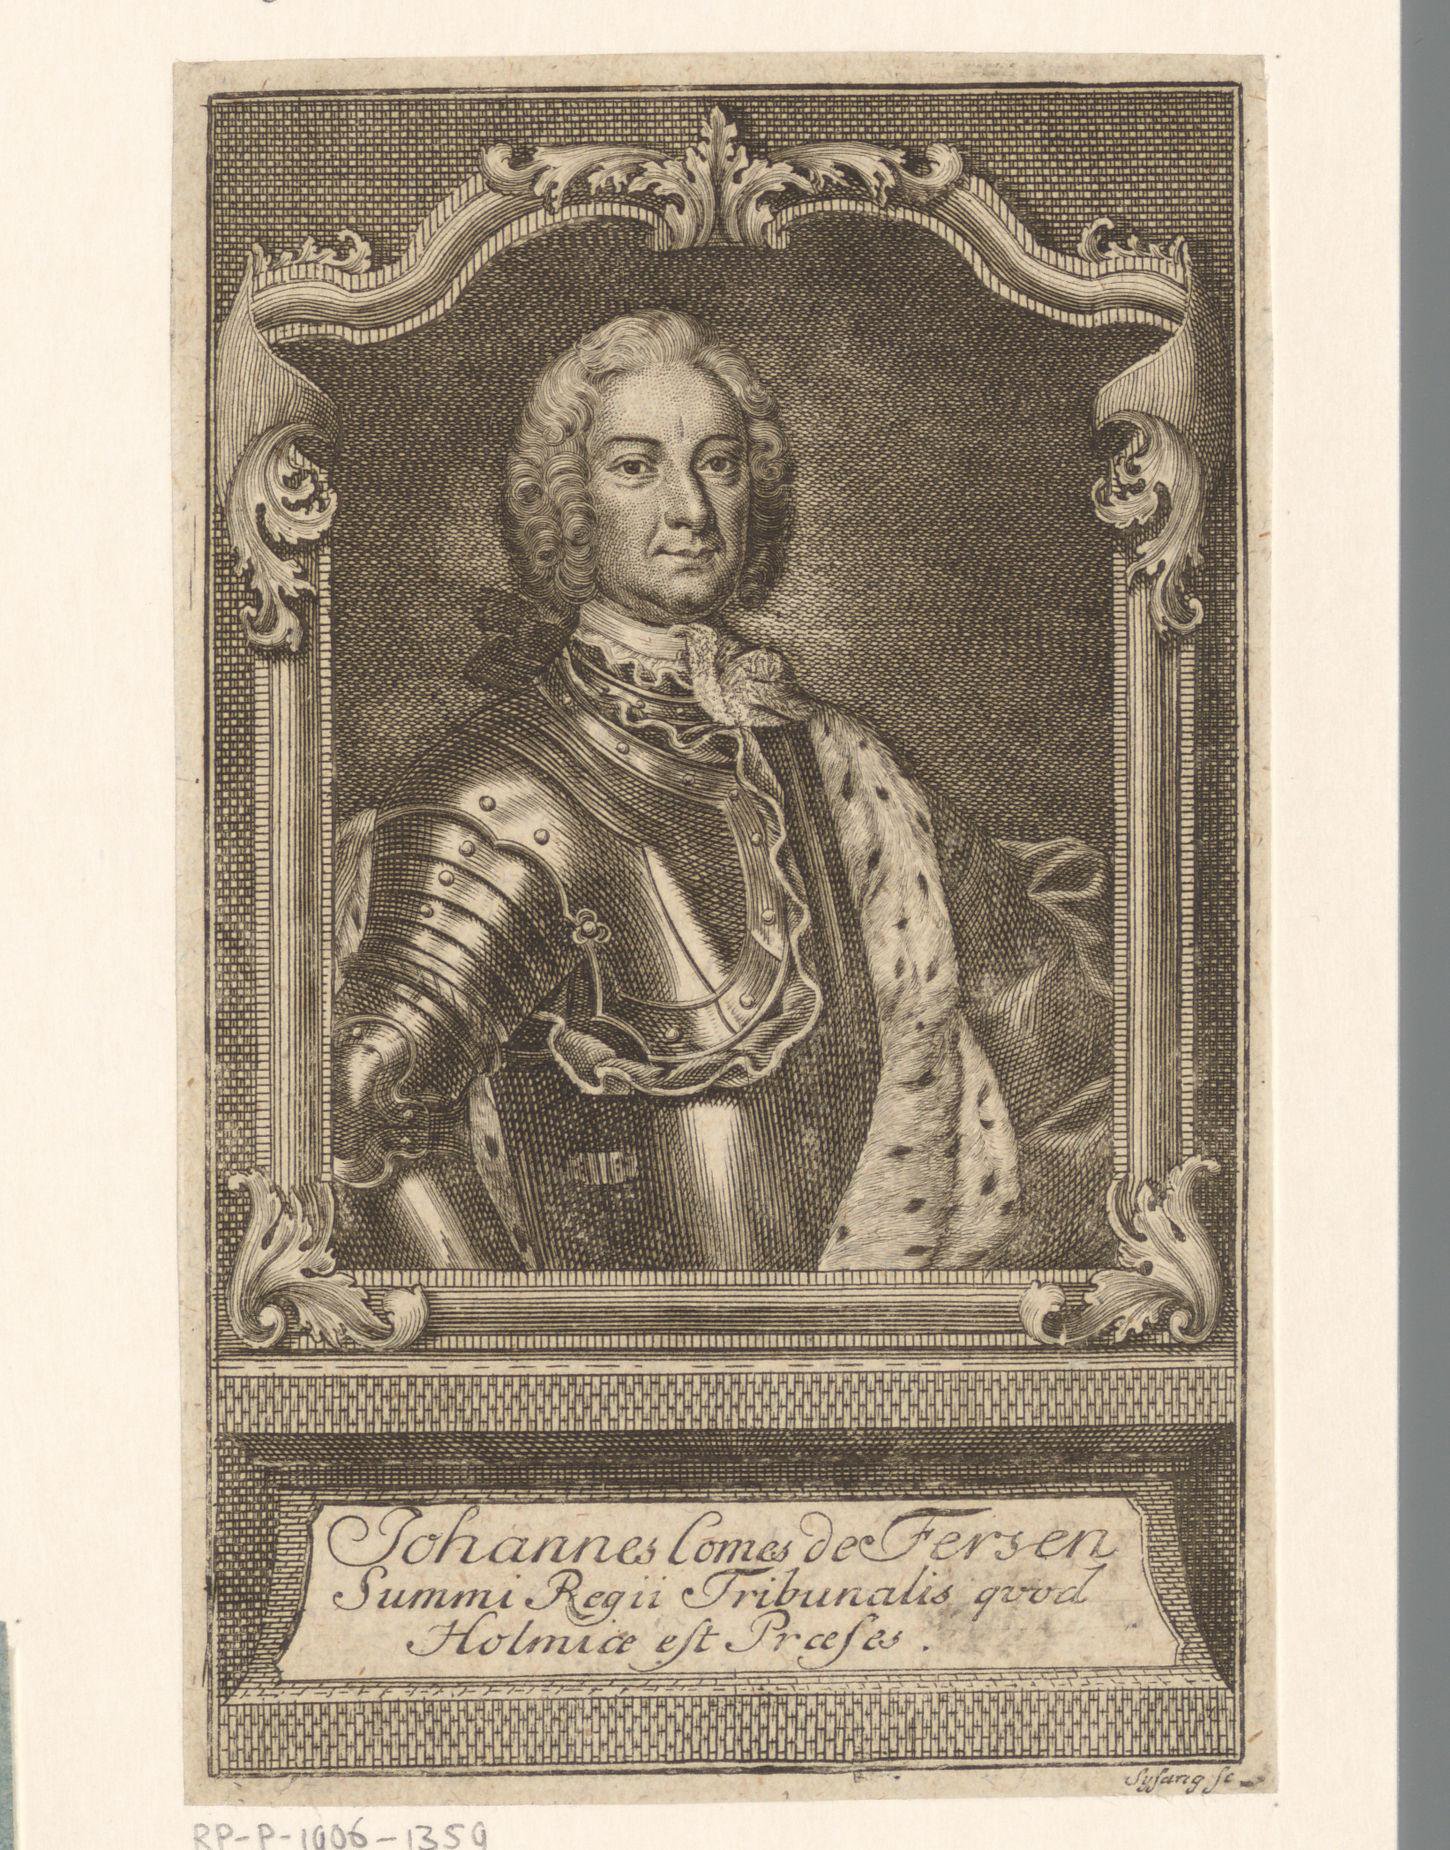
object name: print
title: Portret van Hans von Fersen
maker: johann christoph sysang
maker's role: print maker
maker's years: 1703-1757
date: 1713-1757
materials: paper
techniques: engraving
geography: germany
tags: armour, historical persons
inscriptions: collector's mark: Lugt 2228